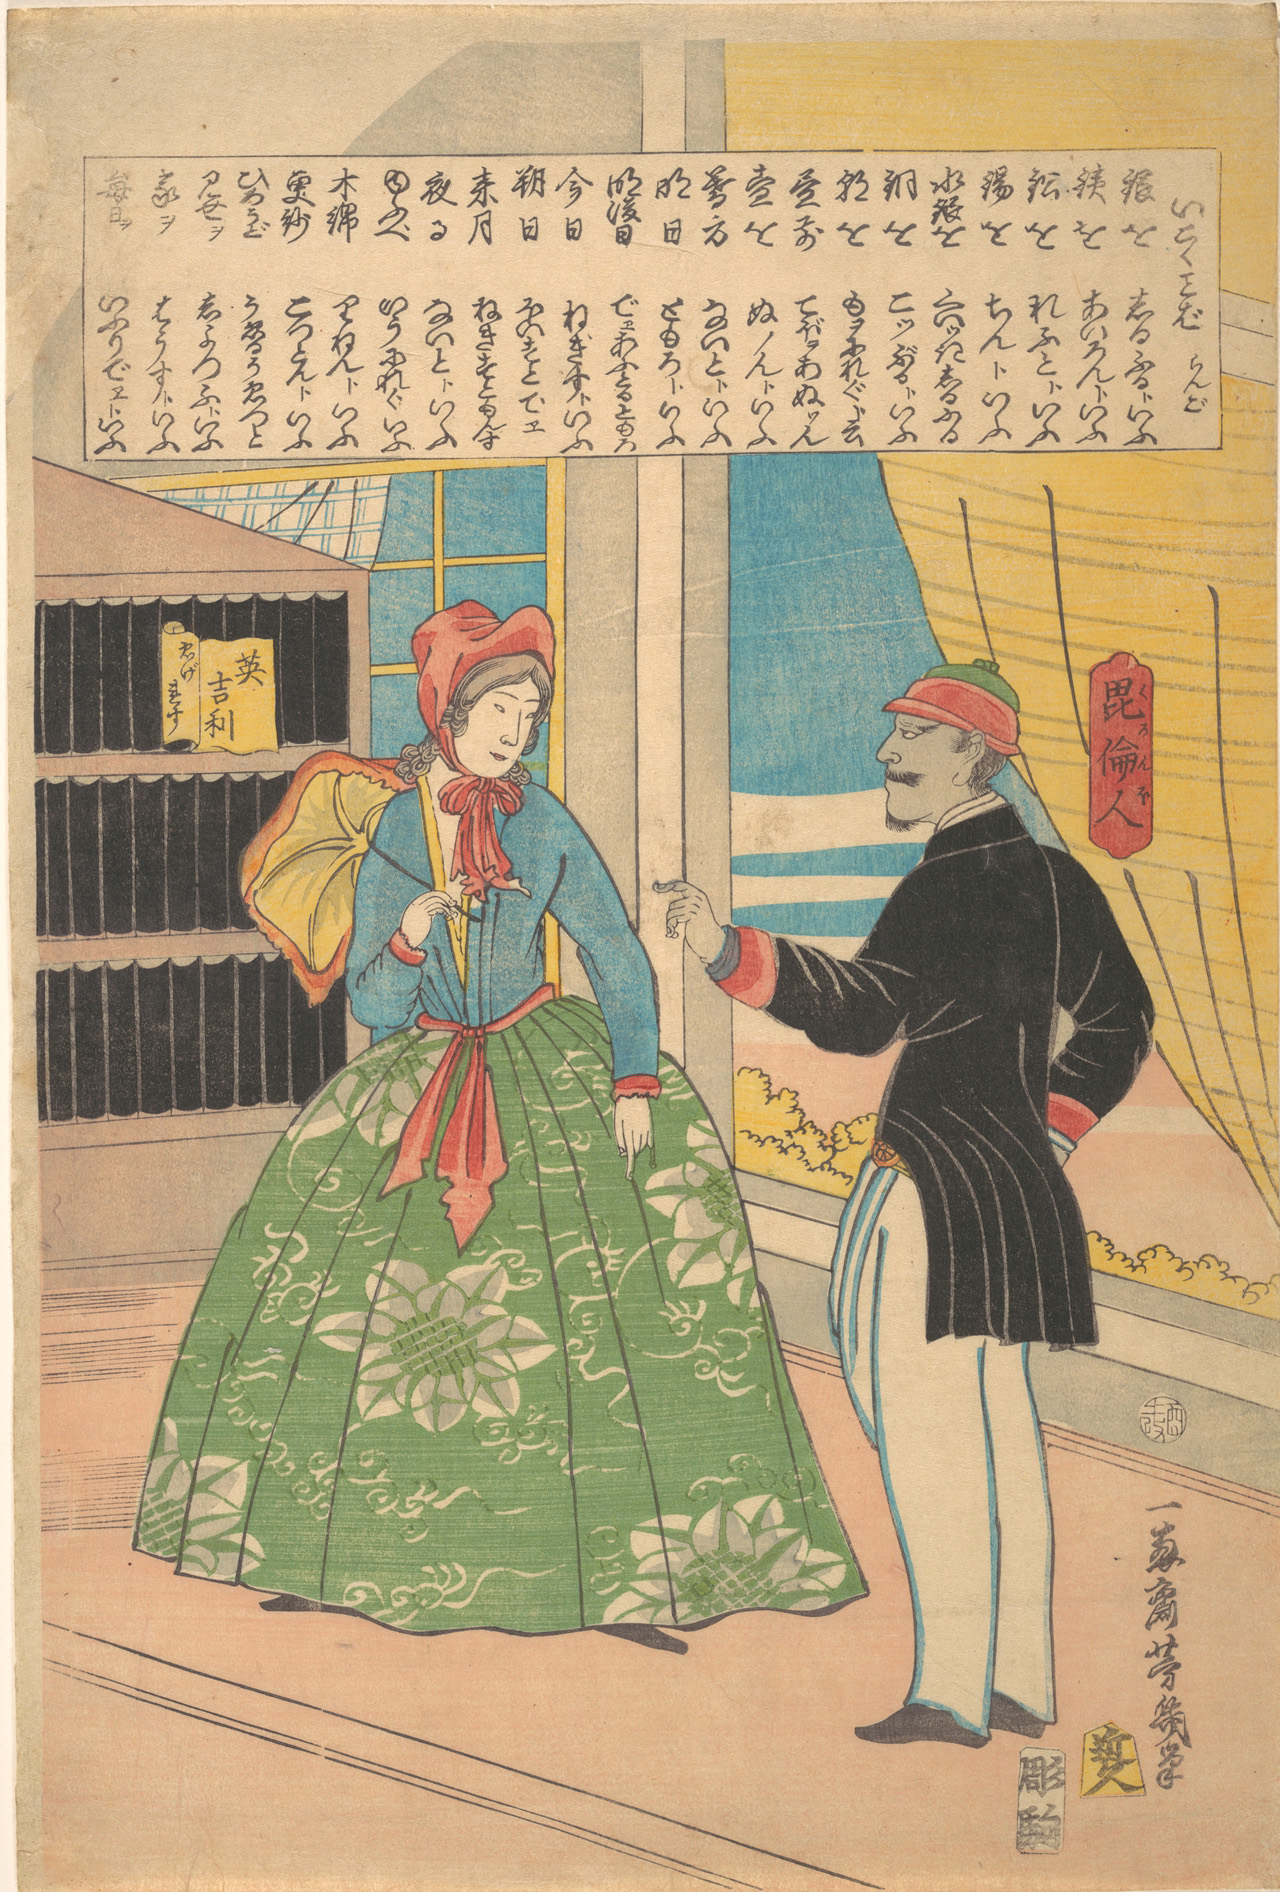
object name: print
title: English Woman with Black Man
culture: japanese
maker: utagawa yoshiiku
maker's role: artist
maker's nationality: japanese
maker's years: 1833-1904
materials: ink, paper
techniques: woodblock print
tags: men,women